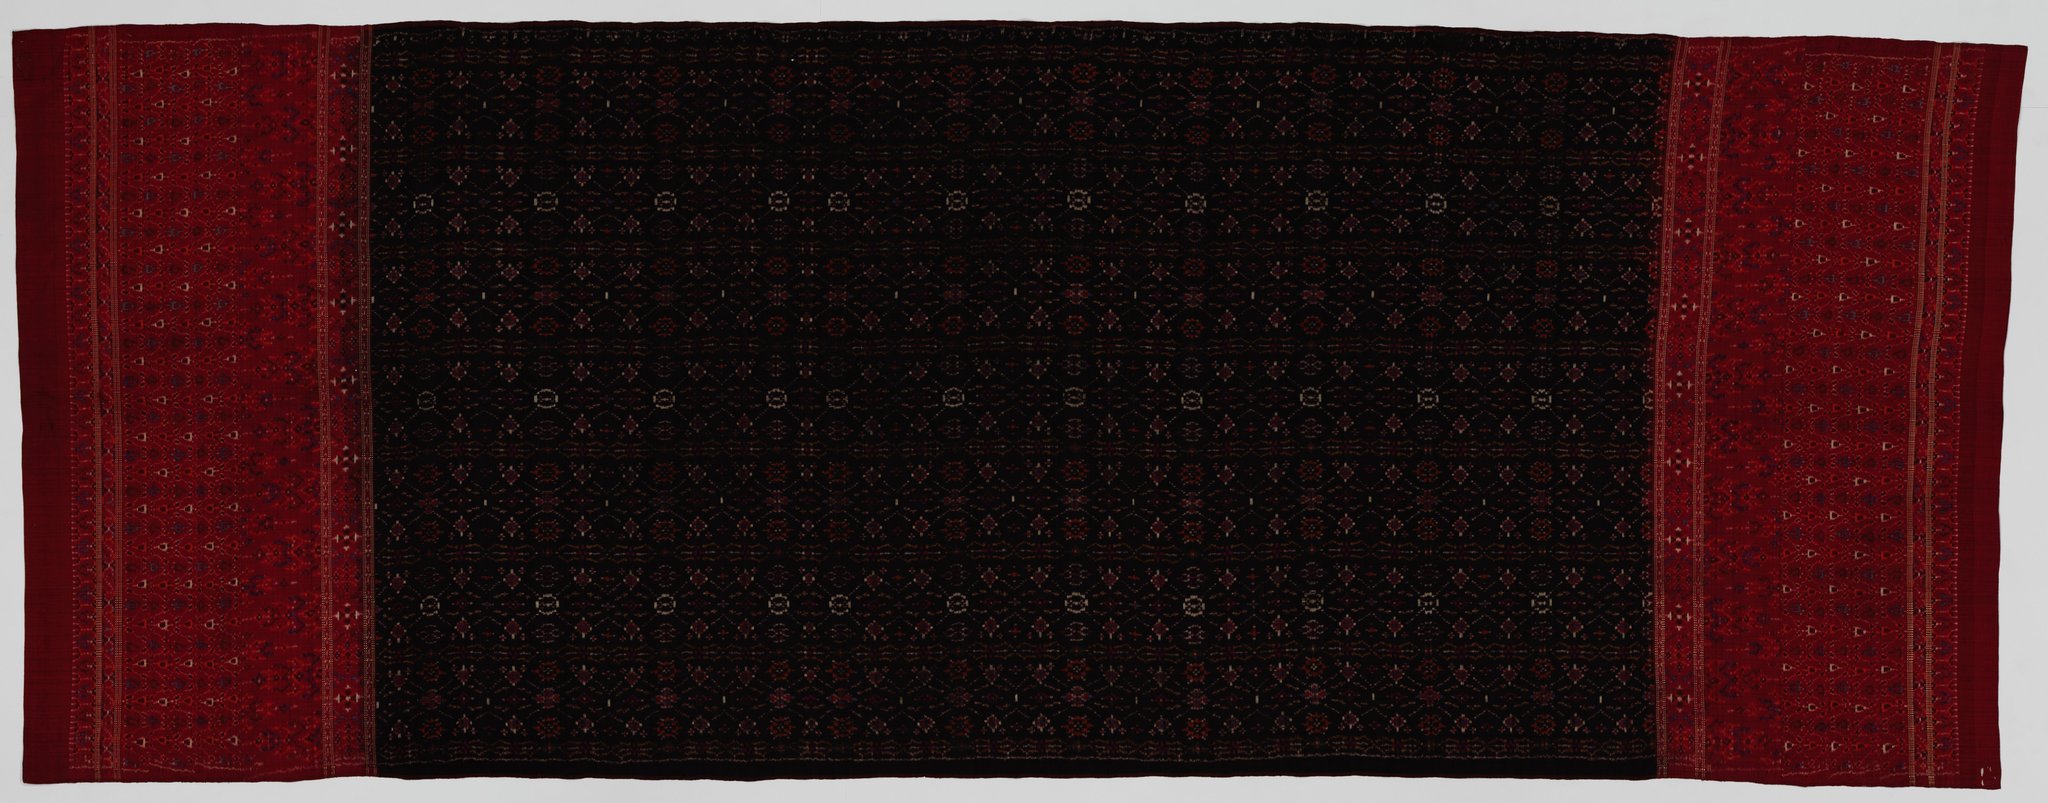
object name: schouderdoek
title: Kain lemar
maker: Anonymous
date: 1900-1949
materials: silk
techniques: weave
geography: malaysia